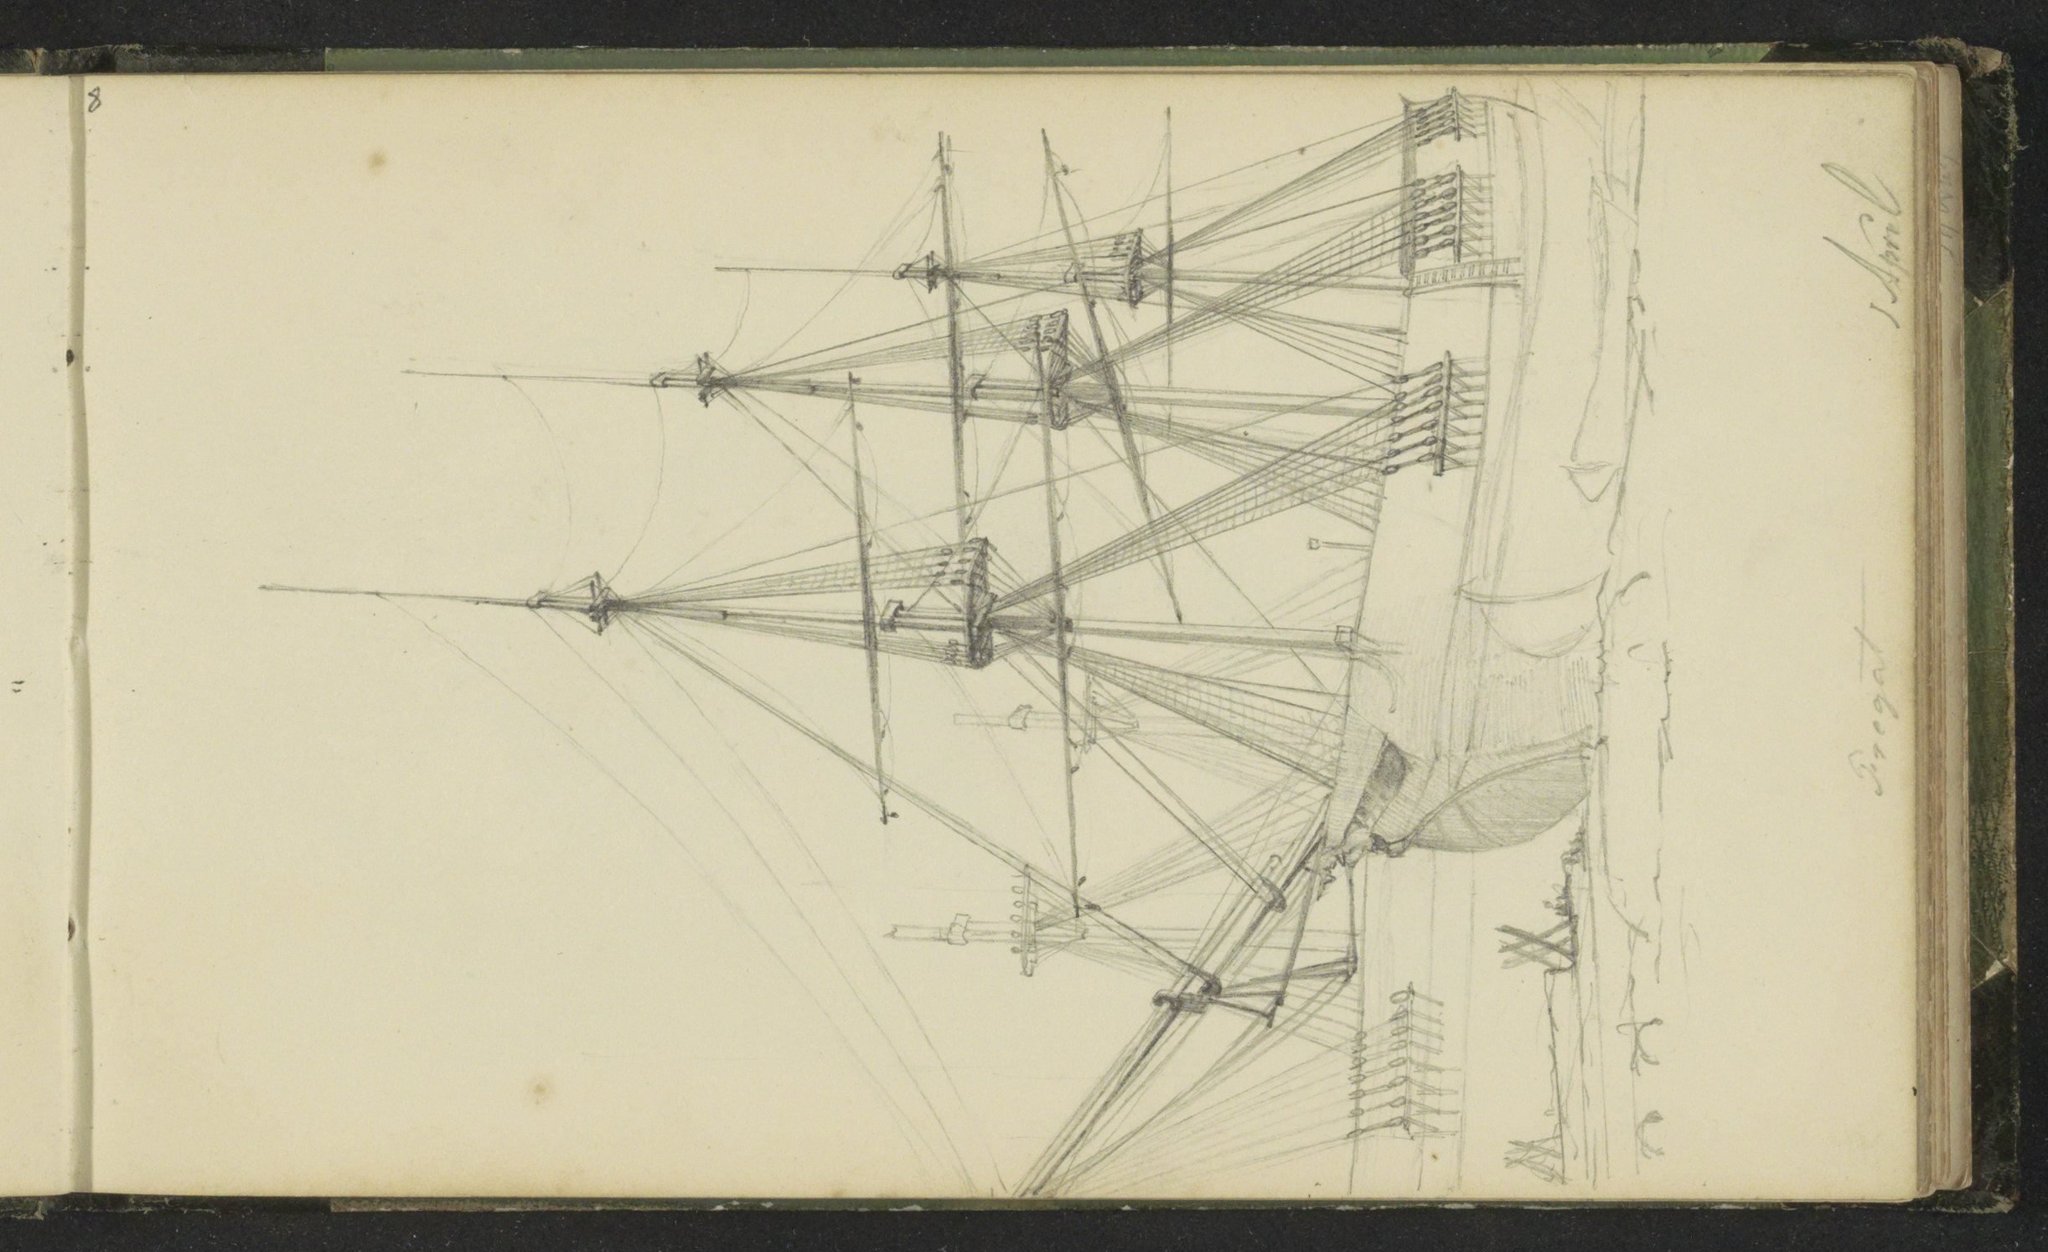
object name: sketchbook leaf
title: Fregat aan een kade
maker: hendrik abraham klinkhamer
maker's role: draughtsman, painter, print maker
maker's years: 1810-1872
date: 1804-1843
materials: paper, pencil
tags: sailing-ship, sailing-boat, pier, quay, wharf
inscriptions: date and inscription: ‘Fregat/ 1 April’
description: Blad 8 recto uit een schetsboek met 40 bladen.